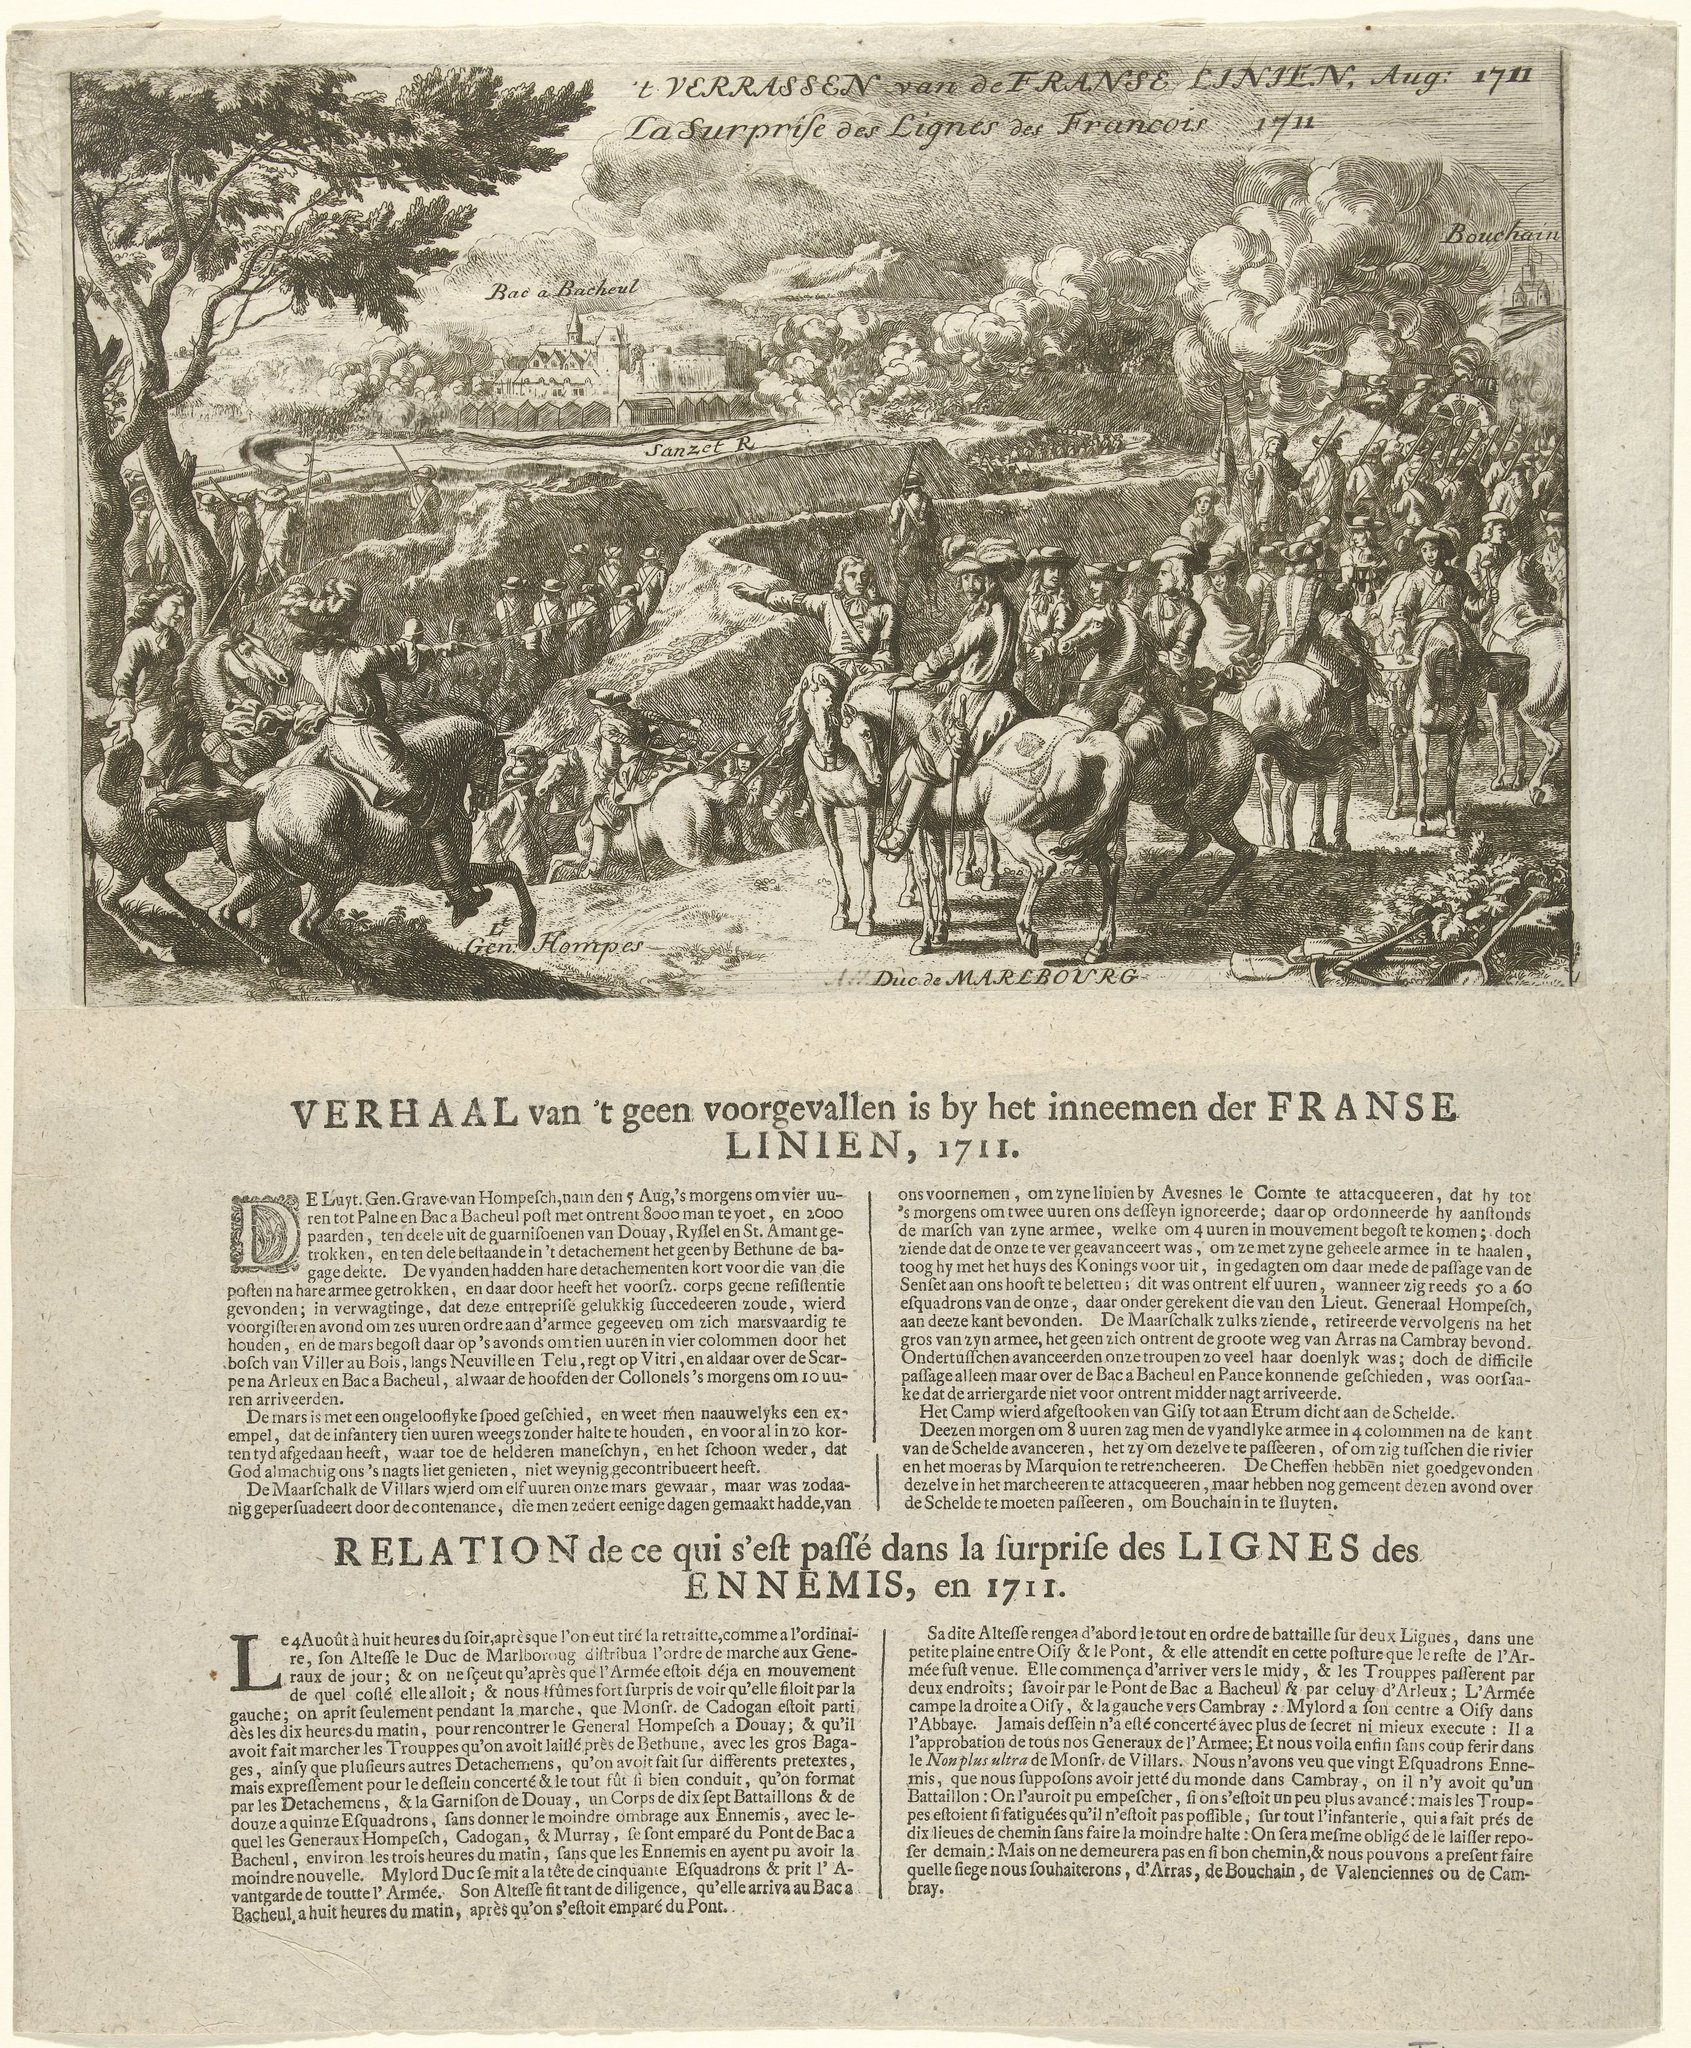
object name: print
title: 't Verrassen van de Franse Linien, Aug: 1711 / La Surprise des Lignes des Francois 1711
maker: Anonymous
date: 1711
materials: paper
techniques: etching, letterpress printing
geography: northern netherlands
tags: john churchill (1e hertog van marlborough), battle (+ land forces)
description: Verrassingsaanval van de Geallieerden onder de hertog van Marlborough op de Franse linies, 5 augustus 1711. Op het blad onder de plaat het verhaal van de actie in het Nederlands en Frans.